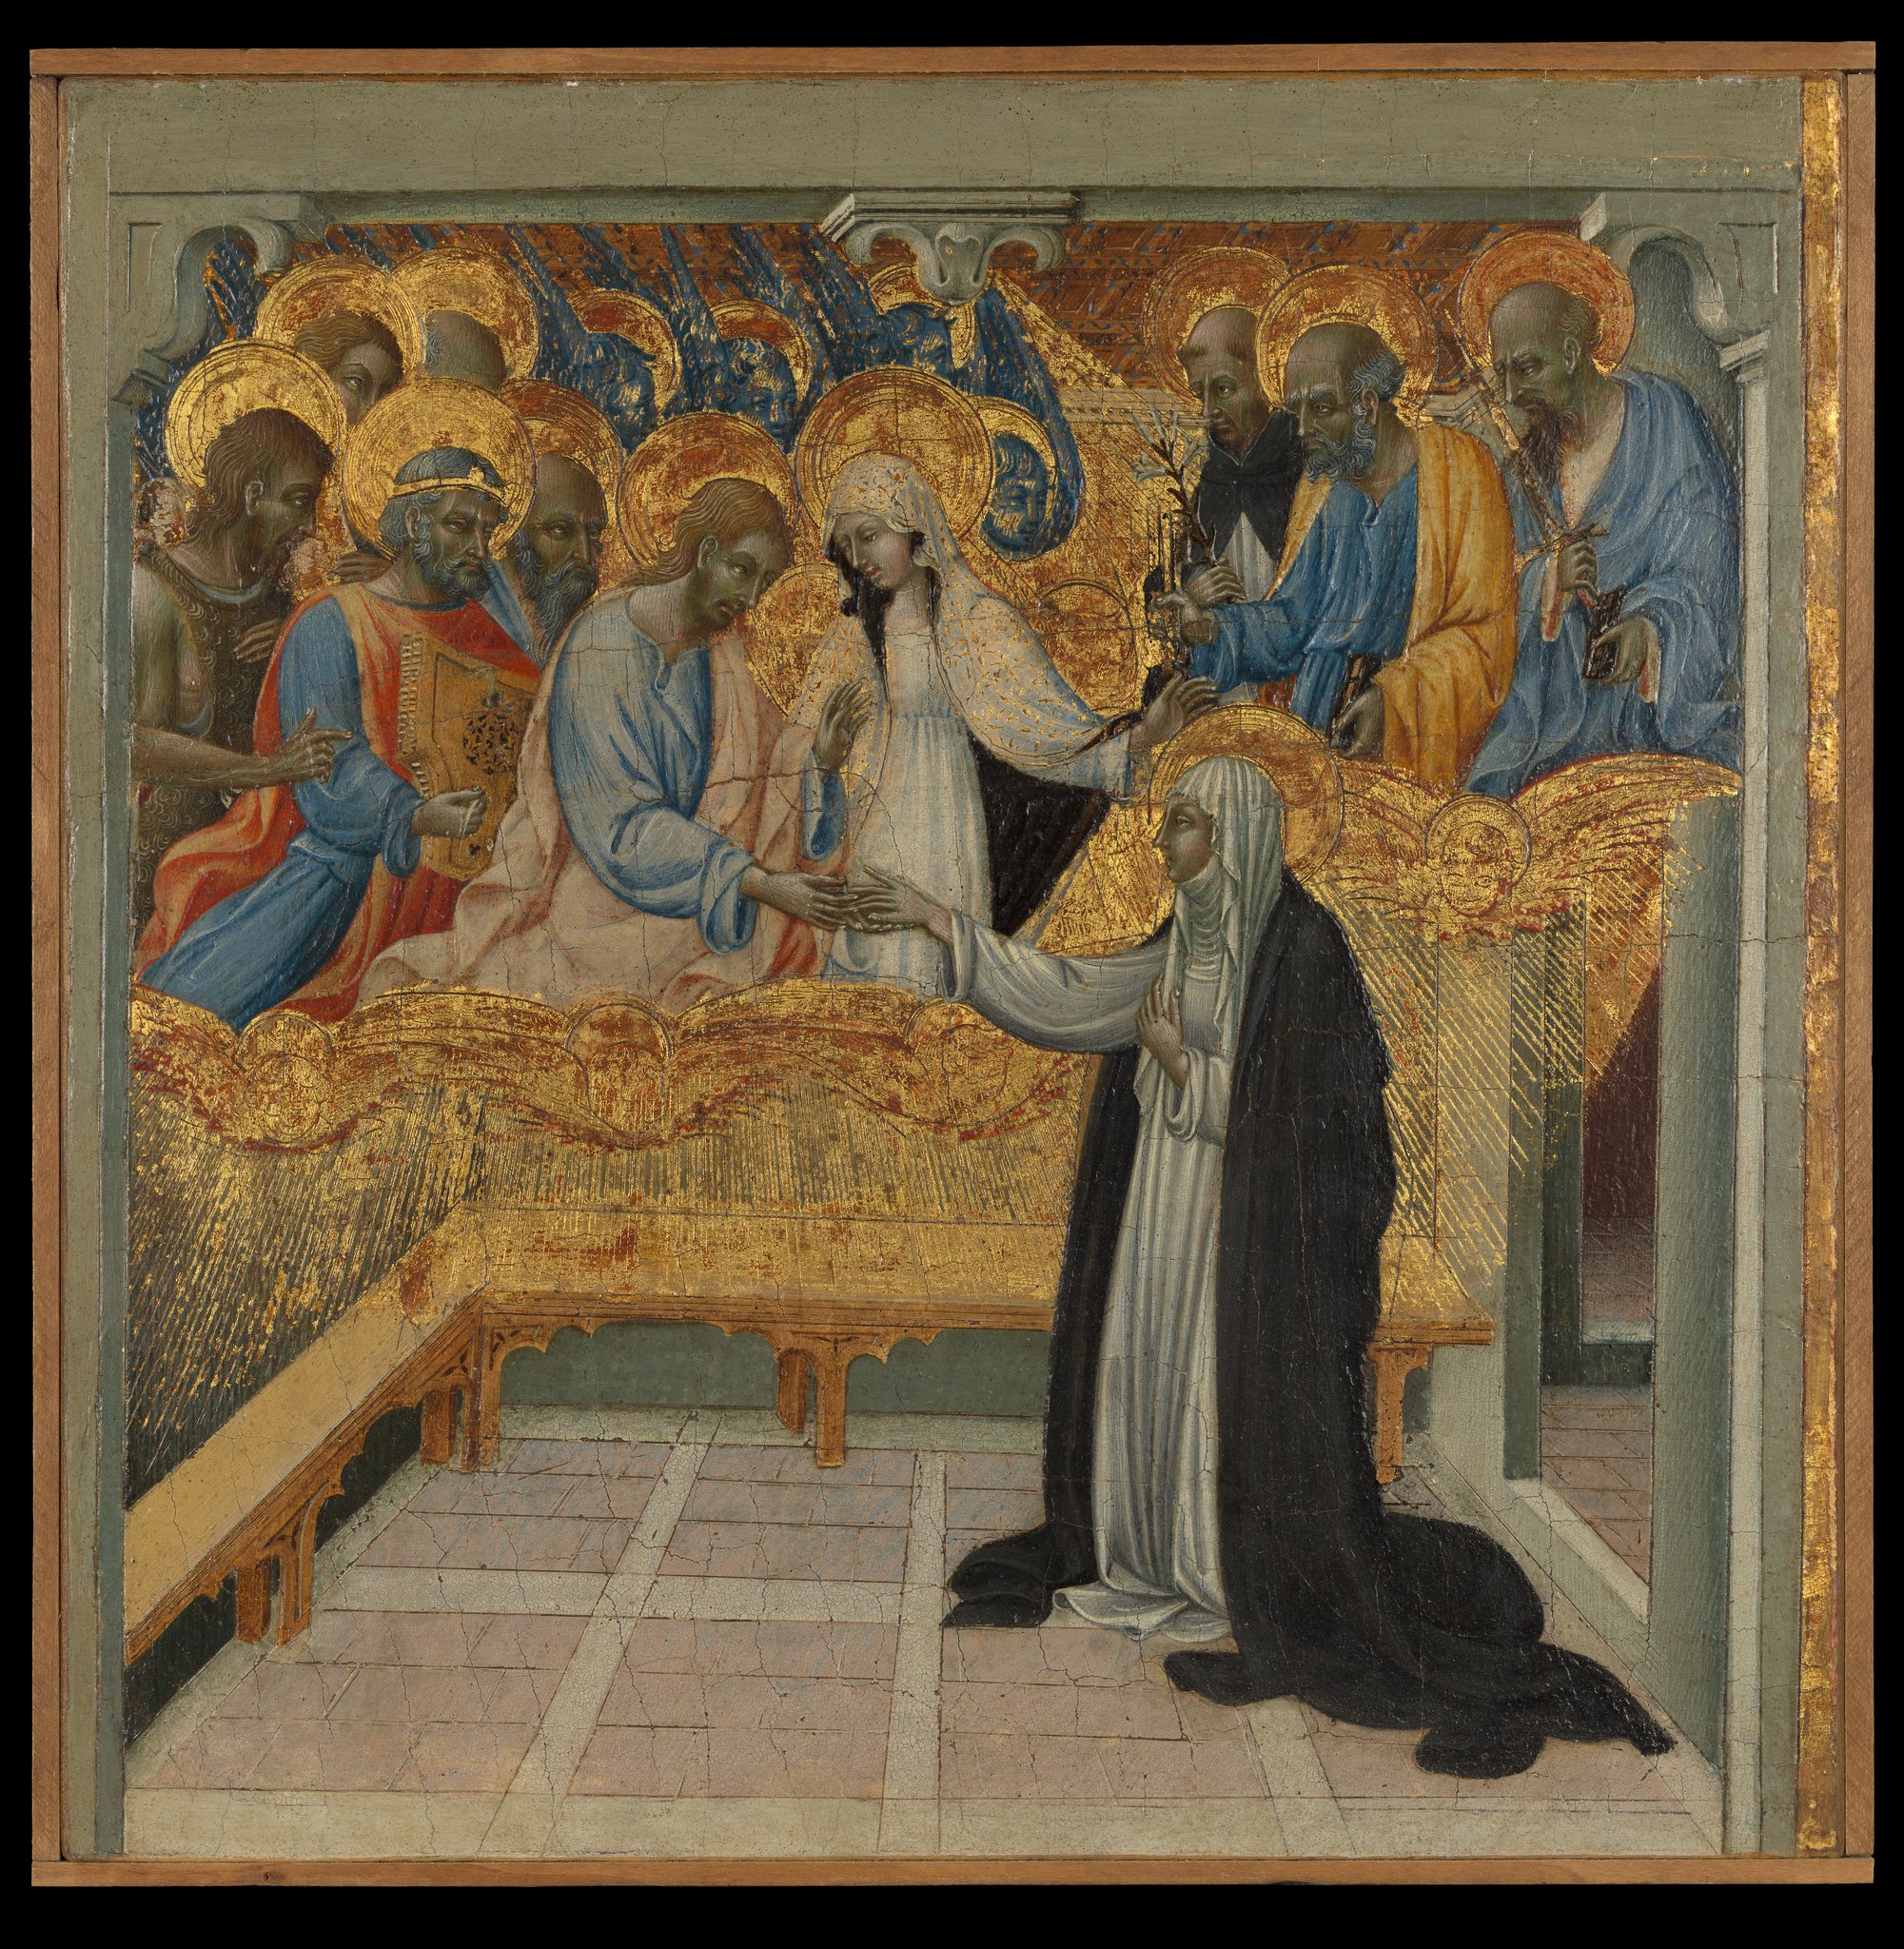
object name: painting, predella panel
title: The Mystic Marriage of Saint Catherine of Siena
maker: giovanni di paolo (giovanni di paolo di grazia)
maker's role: artist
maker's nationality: italian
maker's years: 1398-1482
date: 1417-1482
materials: gold, paint, wood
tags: saint catherine,saint paul,saint peter,jesus